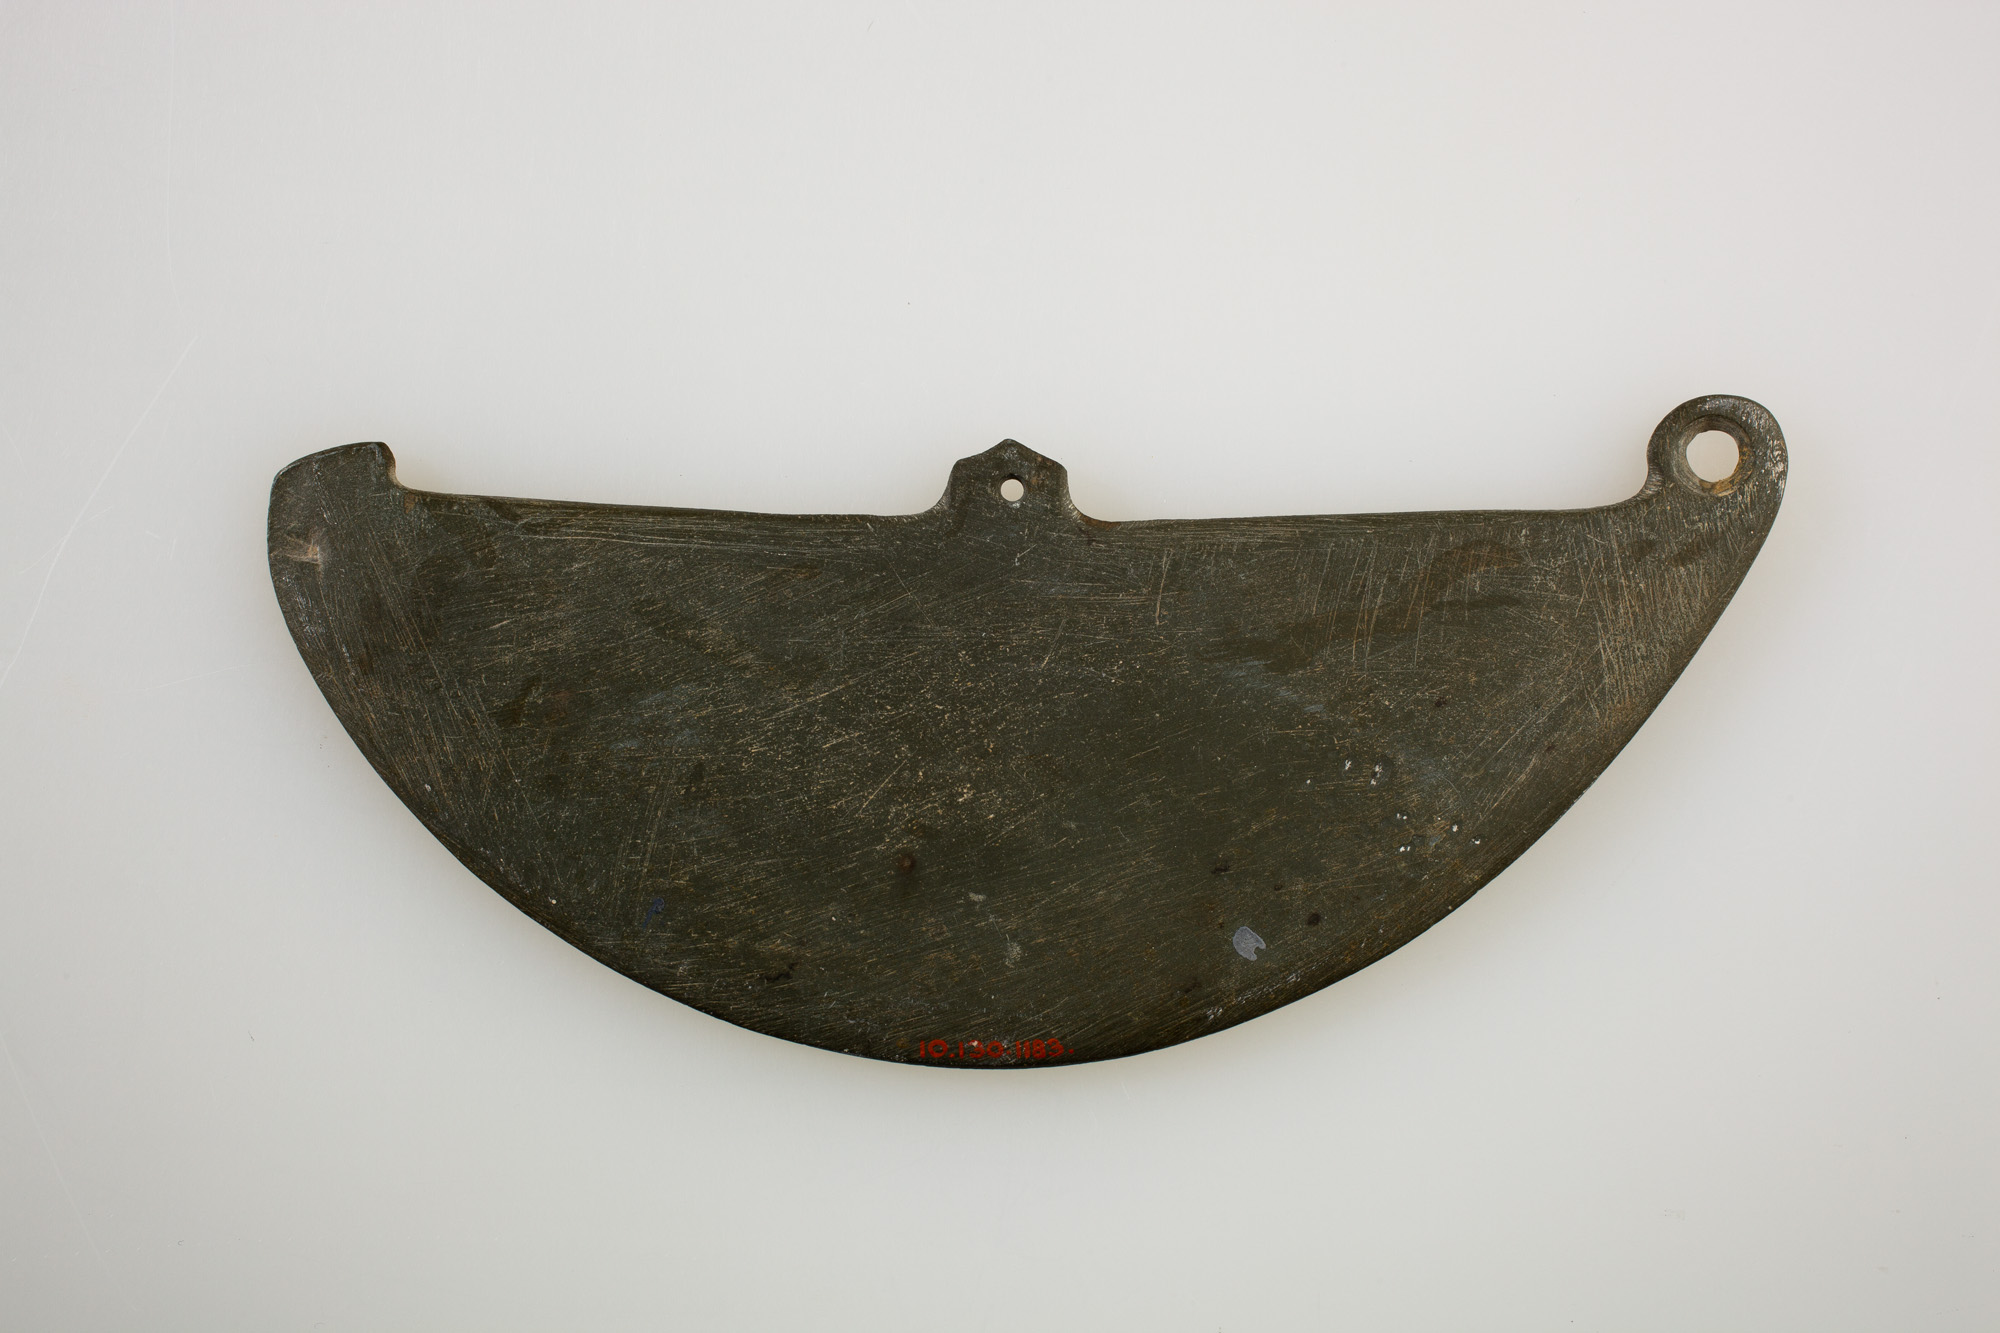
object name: palette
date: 3850-2960 BCE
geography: egypt